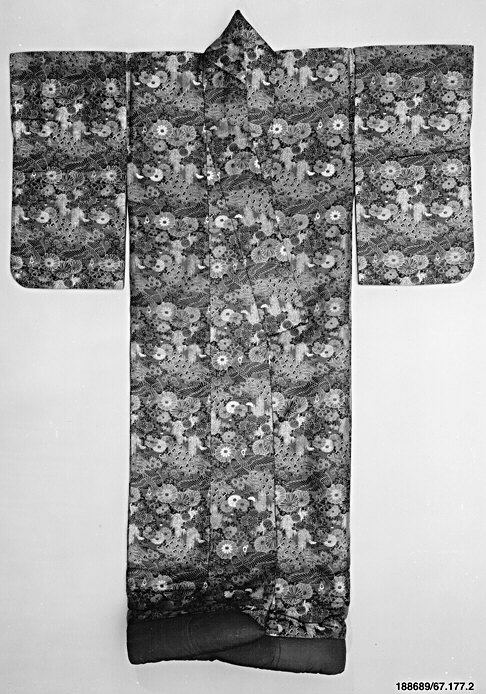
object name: over robe uchikake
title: Over-Robe (Uchikake)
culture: japanese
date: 1851-1900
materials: metal thread, silk